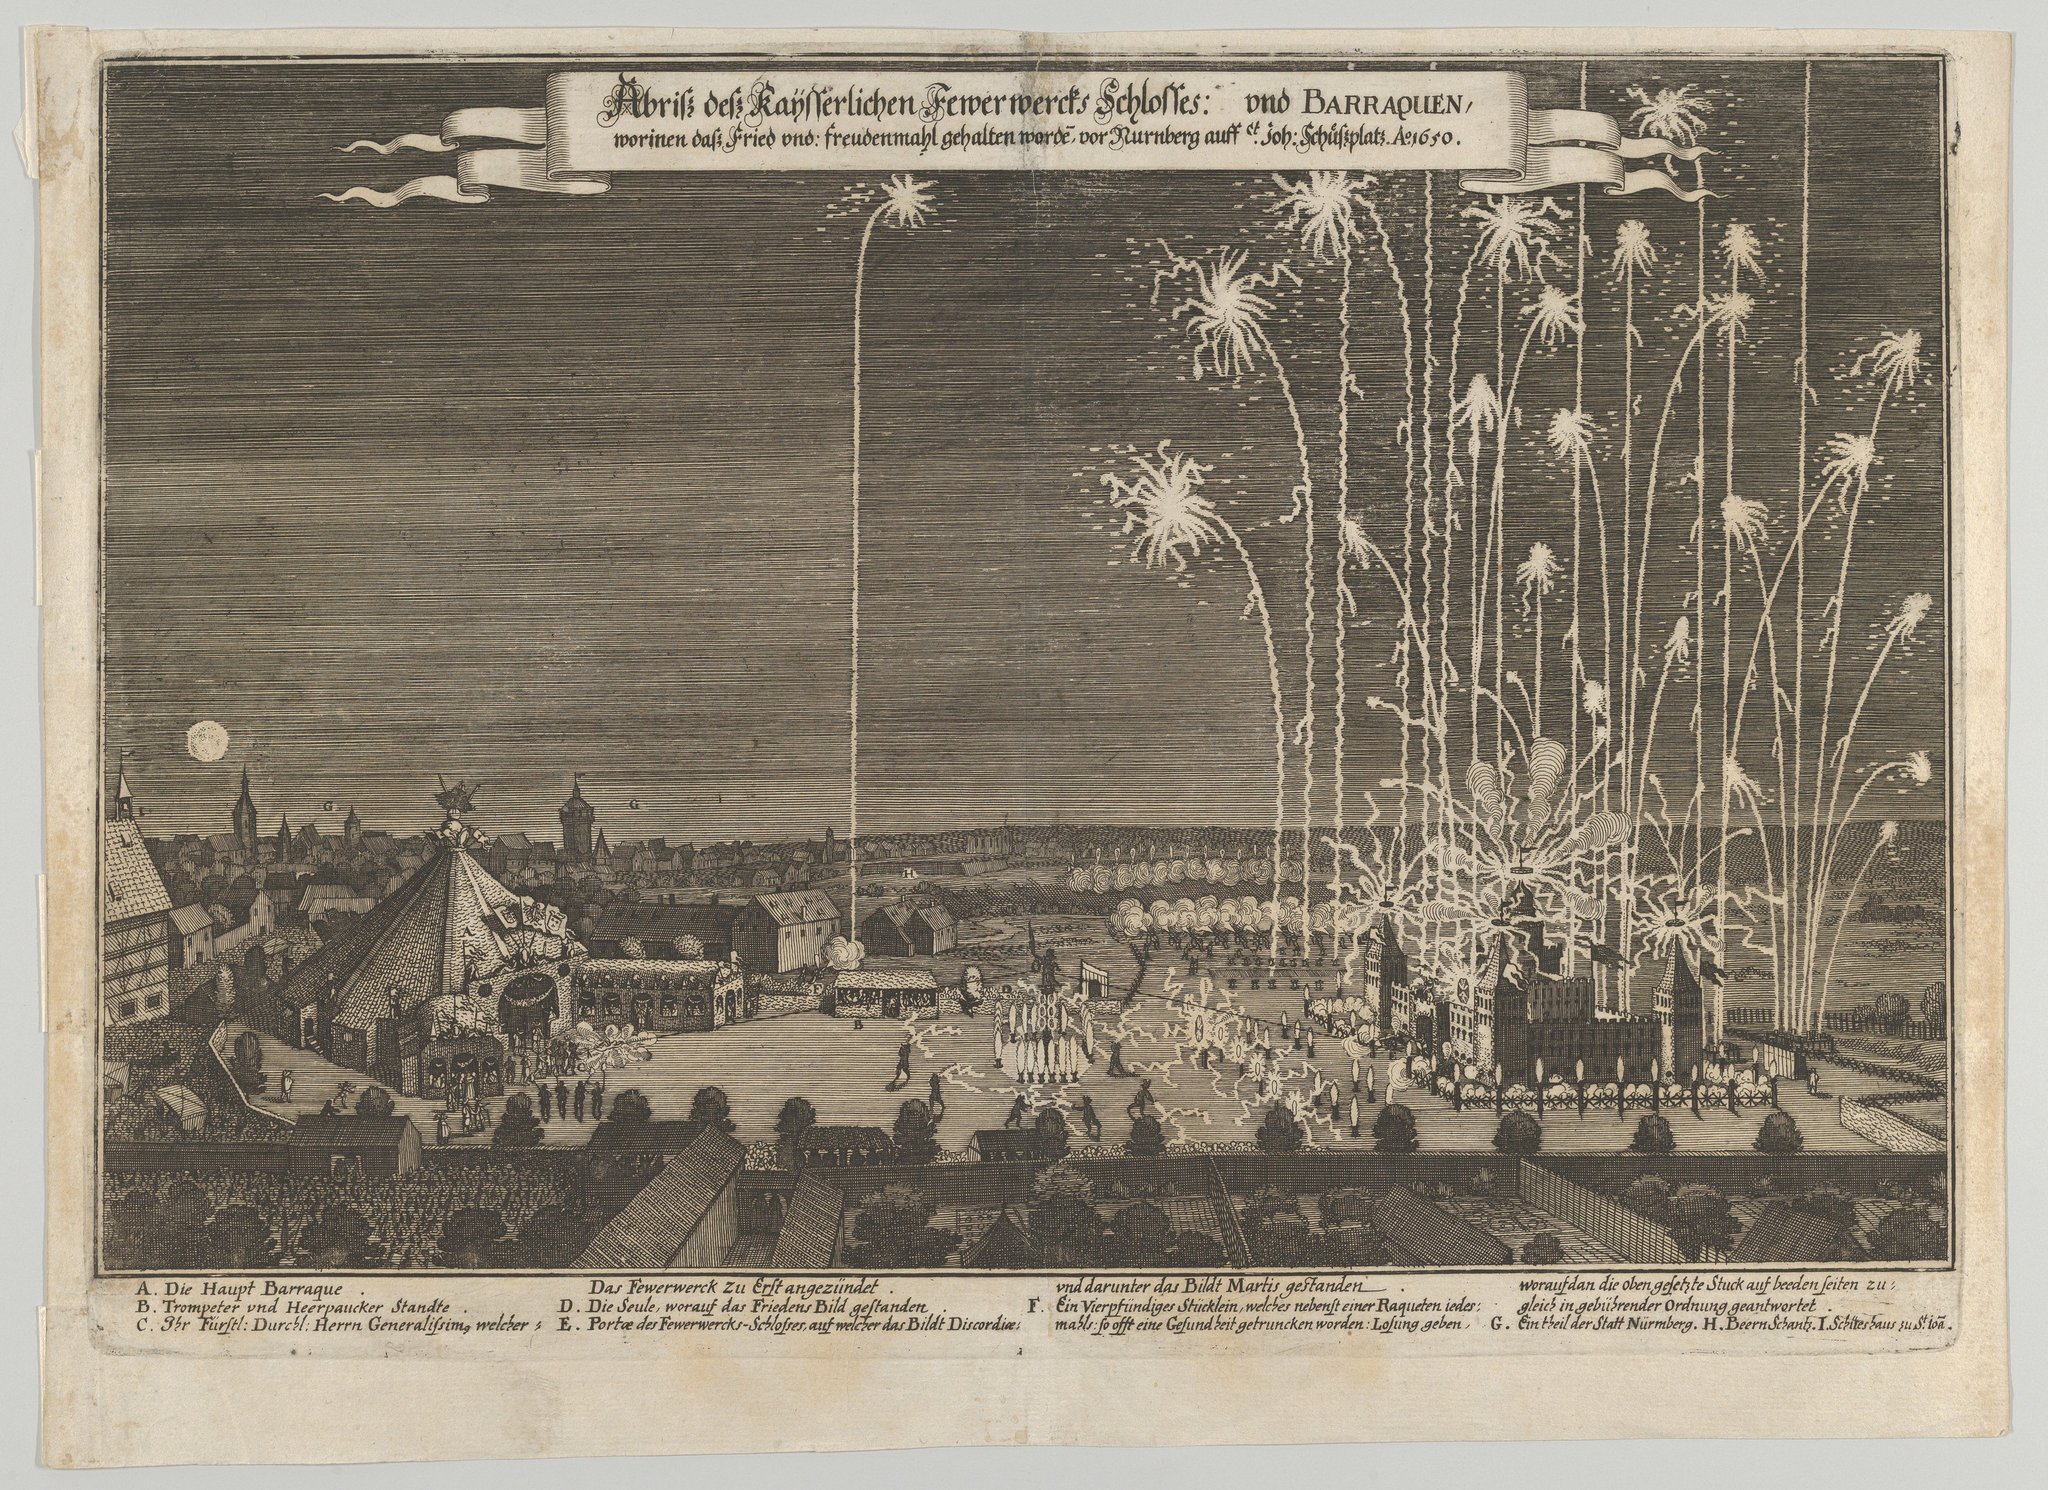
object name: print, fete, ornament architecture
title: Fireworks display celebrating the end of the Thirty Years War, Nuremberg, 1650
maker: Anonymous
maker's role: artist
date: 1650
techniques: etching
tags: fireworks